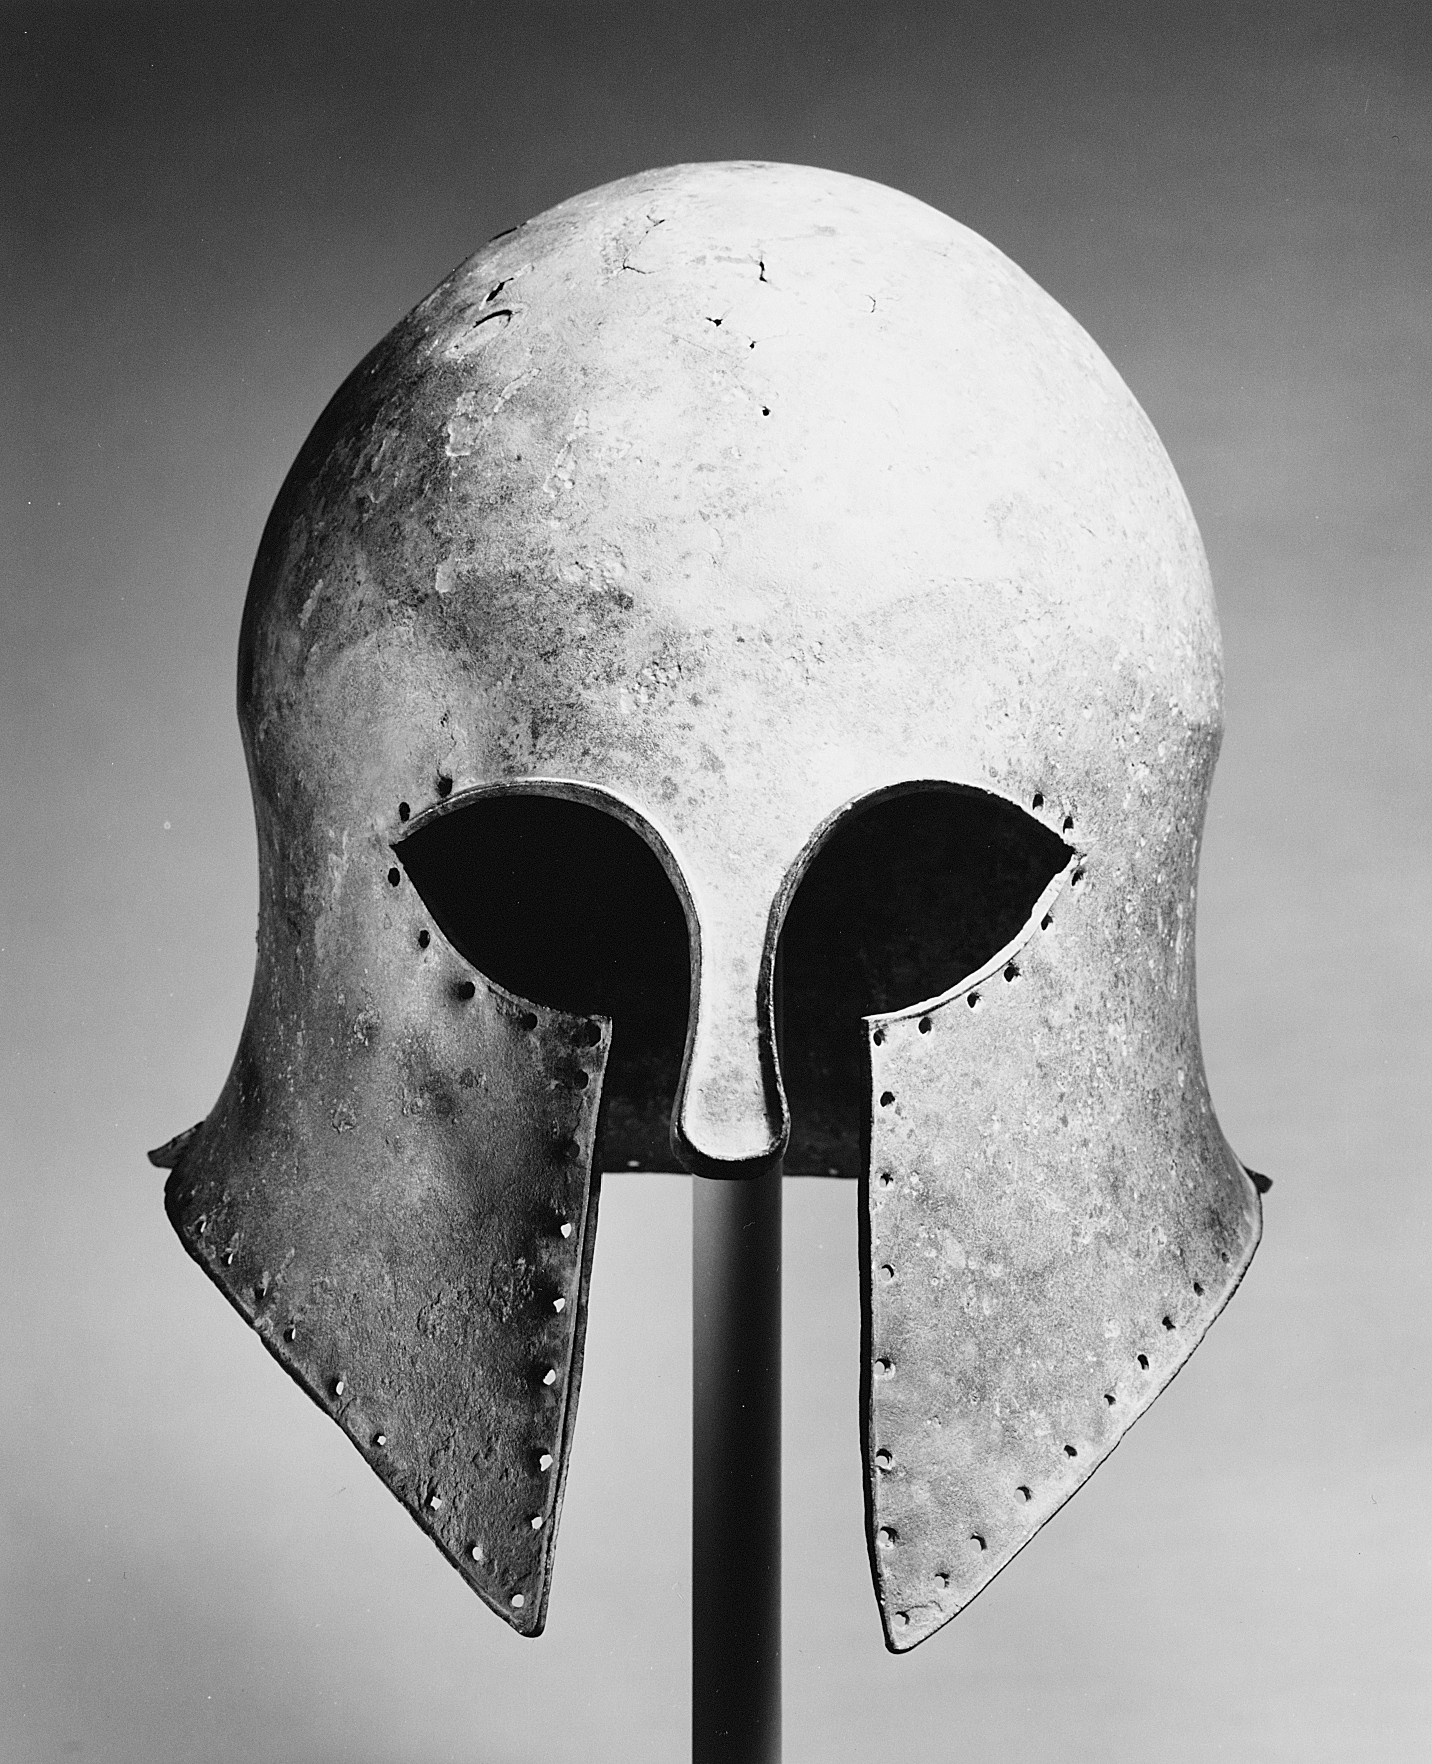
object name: helmet of corinthian type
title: Bronze helmet of Corinthian type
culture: greek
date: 534-501 BCE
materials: bronze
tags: helmets